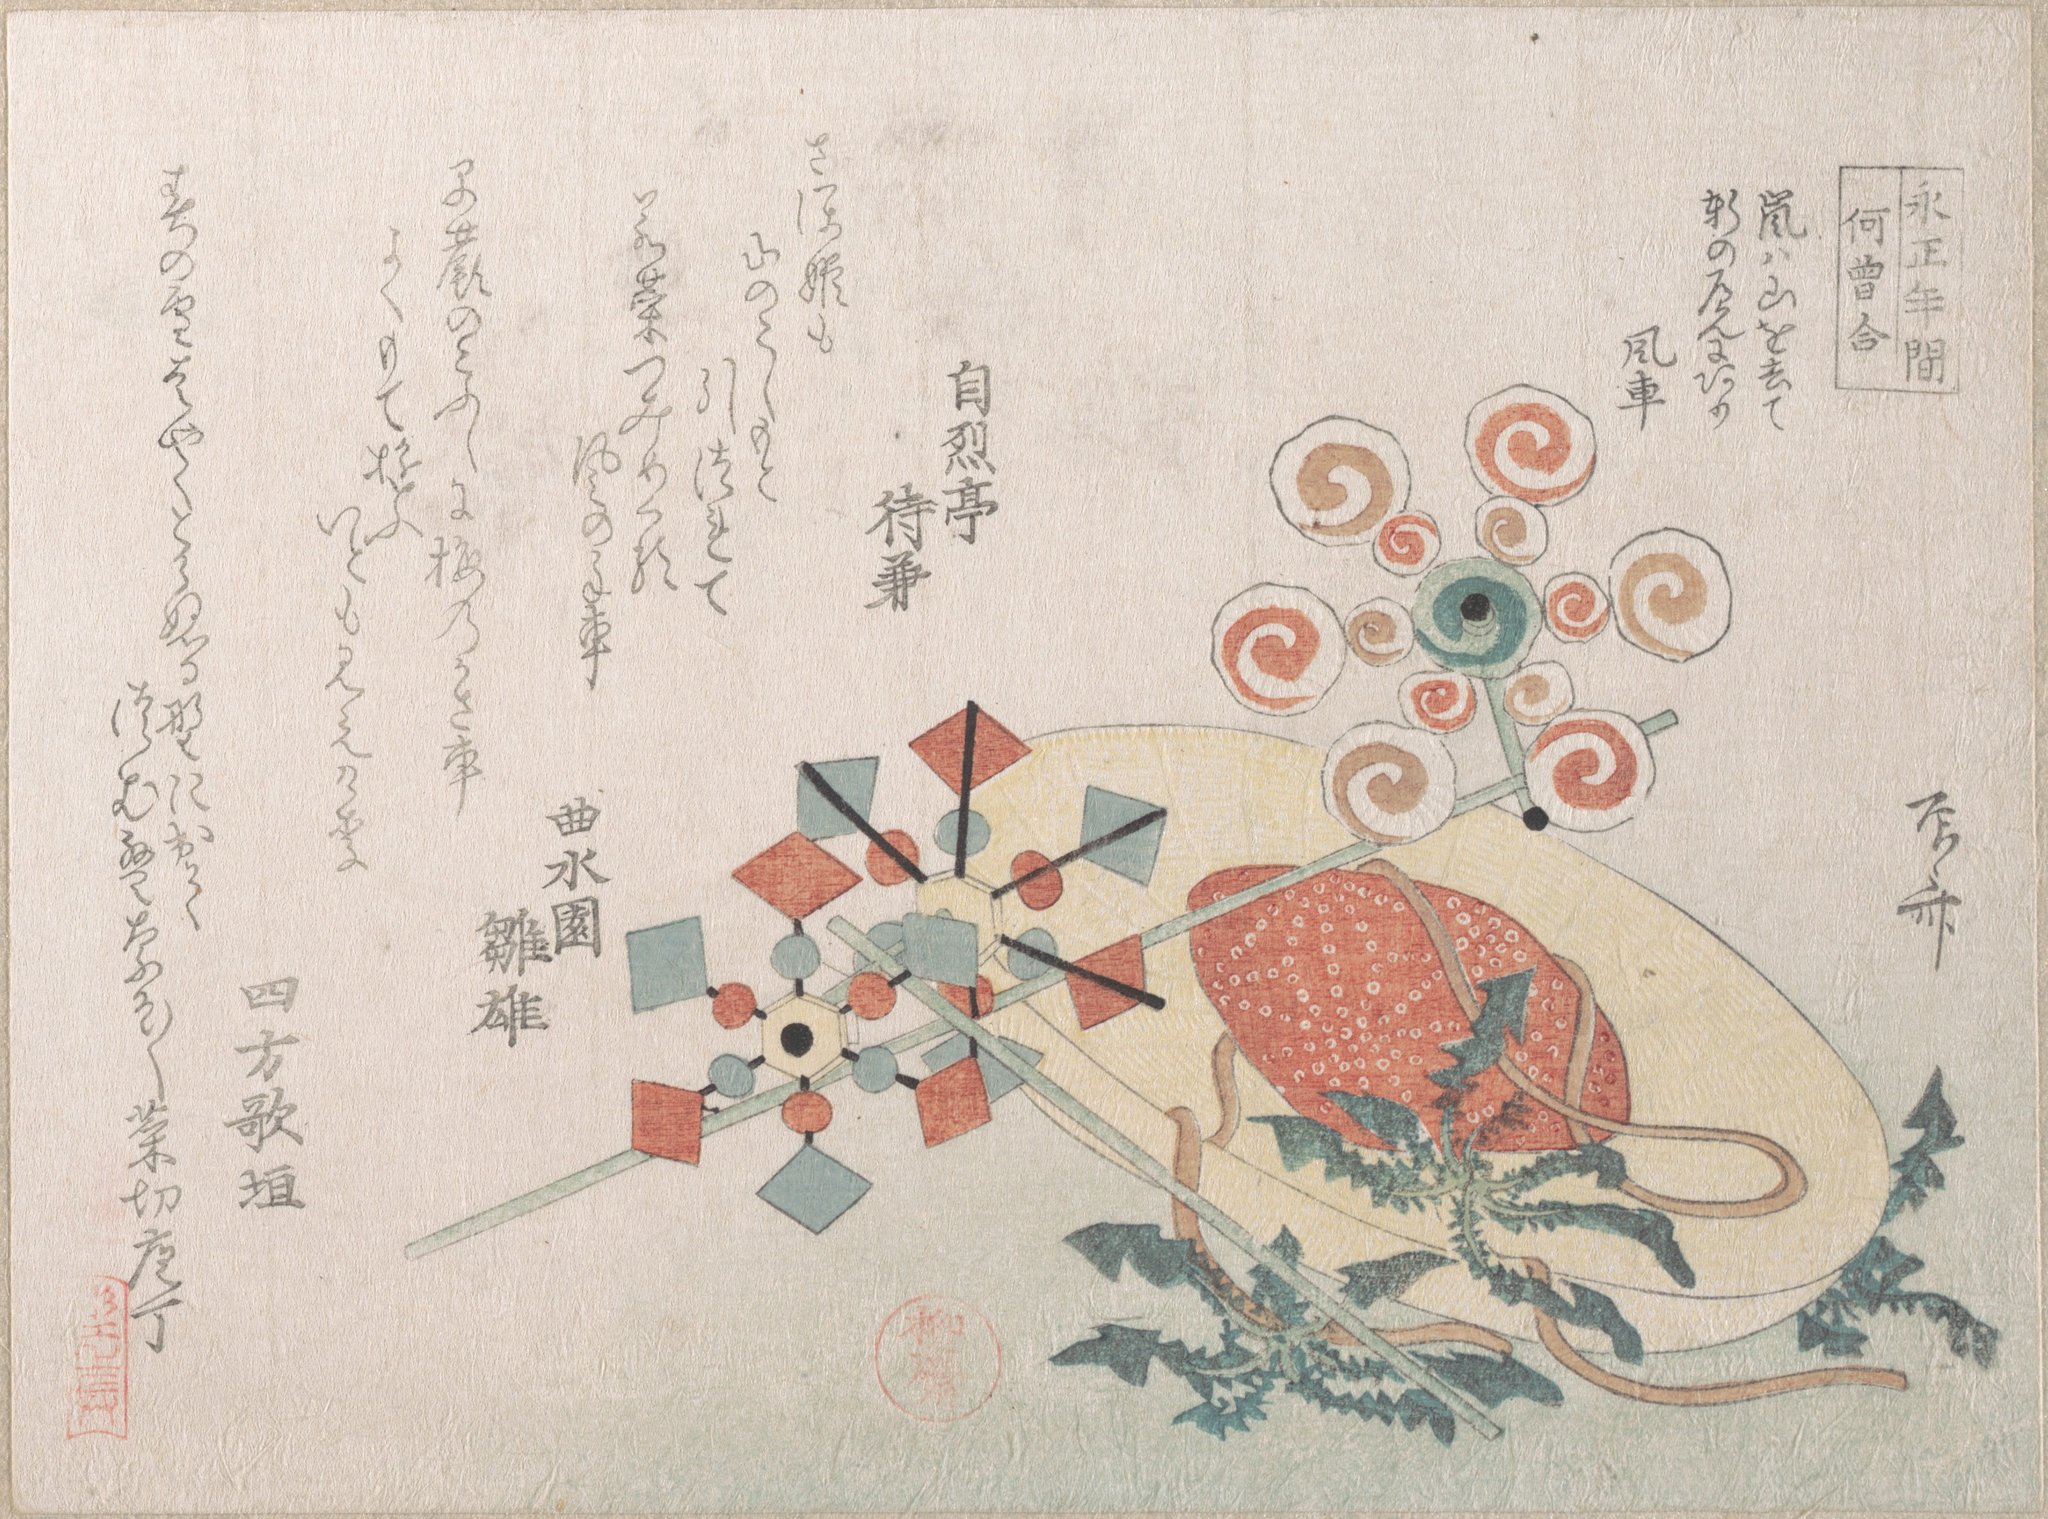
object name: print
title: Straw Hat for Tavel and Toys of Windmills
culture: japanese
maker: ryūryūkyo shinsai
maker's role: artist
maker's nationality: japanese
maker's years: 1799-1823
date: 1801-1900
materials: ink, paper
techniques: surimono, woodblock print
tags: hats,toys